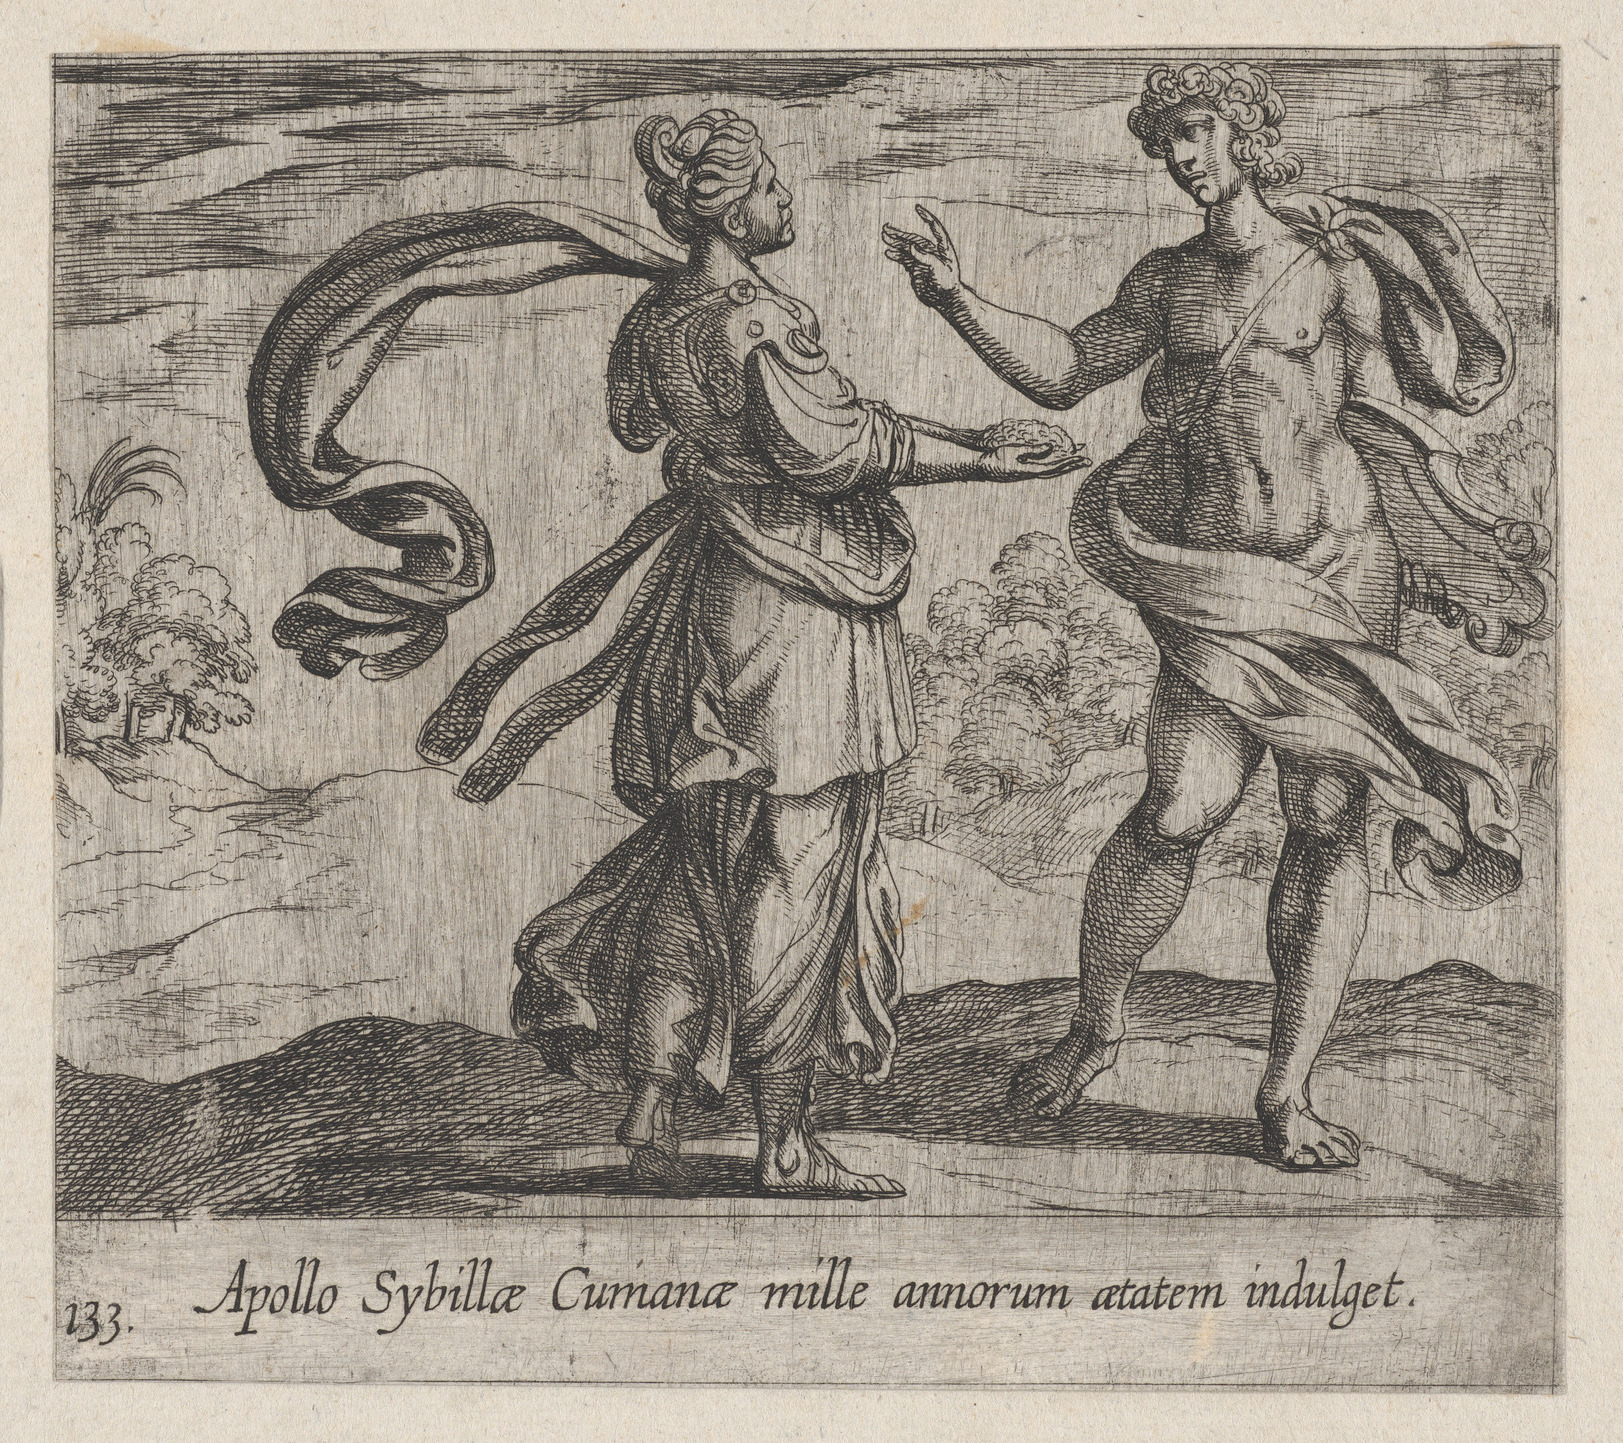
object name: print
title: Apollo Granting the Cumaean Sybil's Wish (Apollo Sybillae Cumanae mille annorum atatem indulget), from Ovid's The Metamorphoses, plate 133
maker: antonio tempesta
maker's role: artist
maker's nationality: italian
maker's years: 1555-1630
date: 1606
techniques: etching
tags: women,apollo